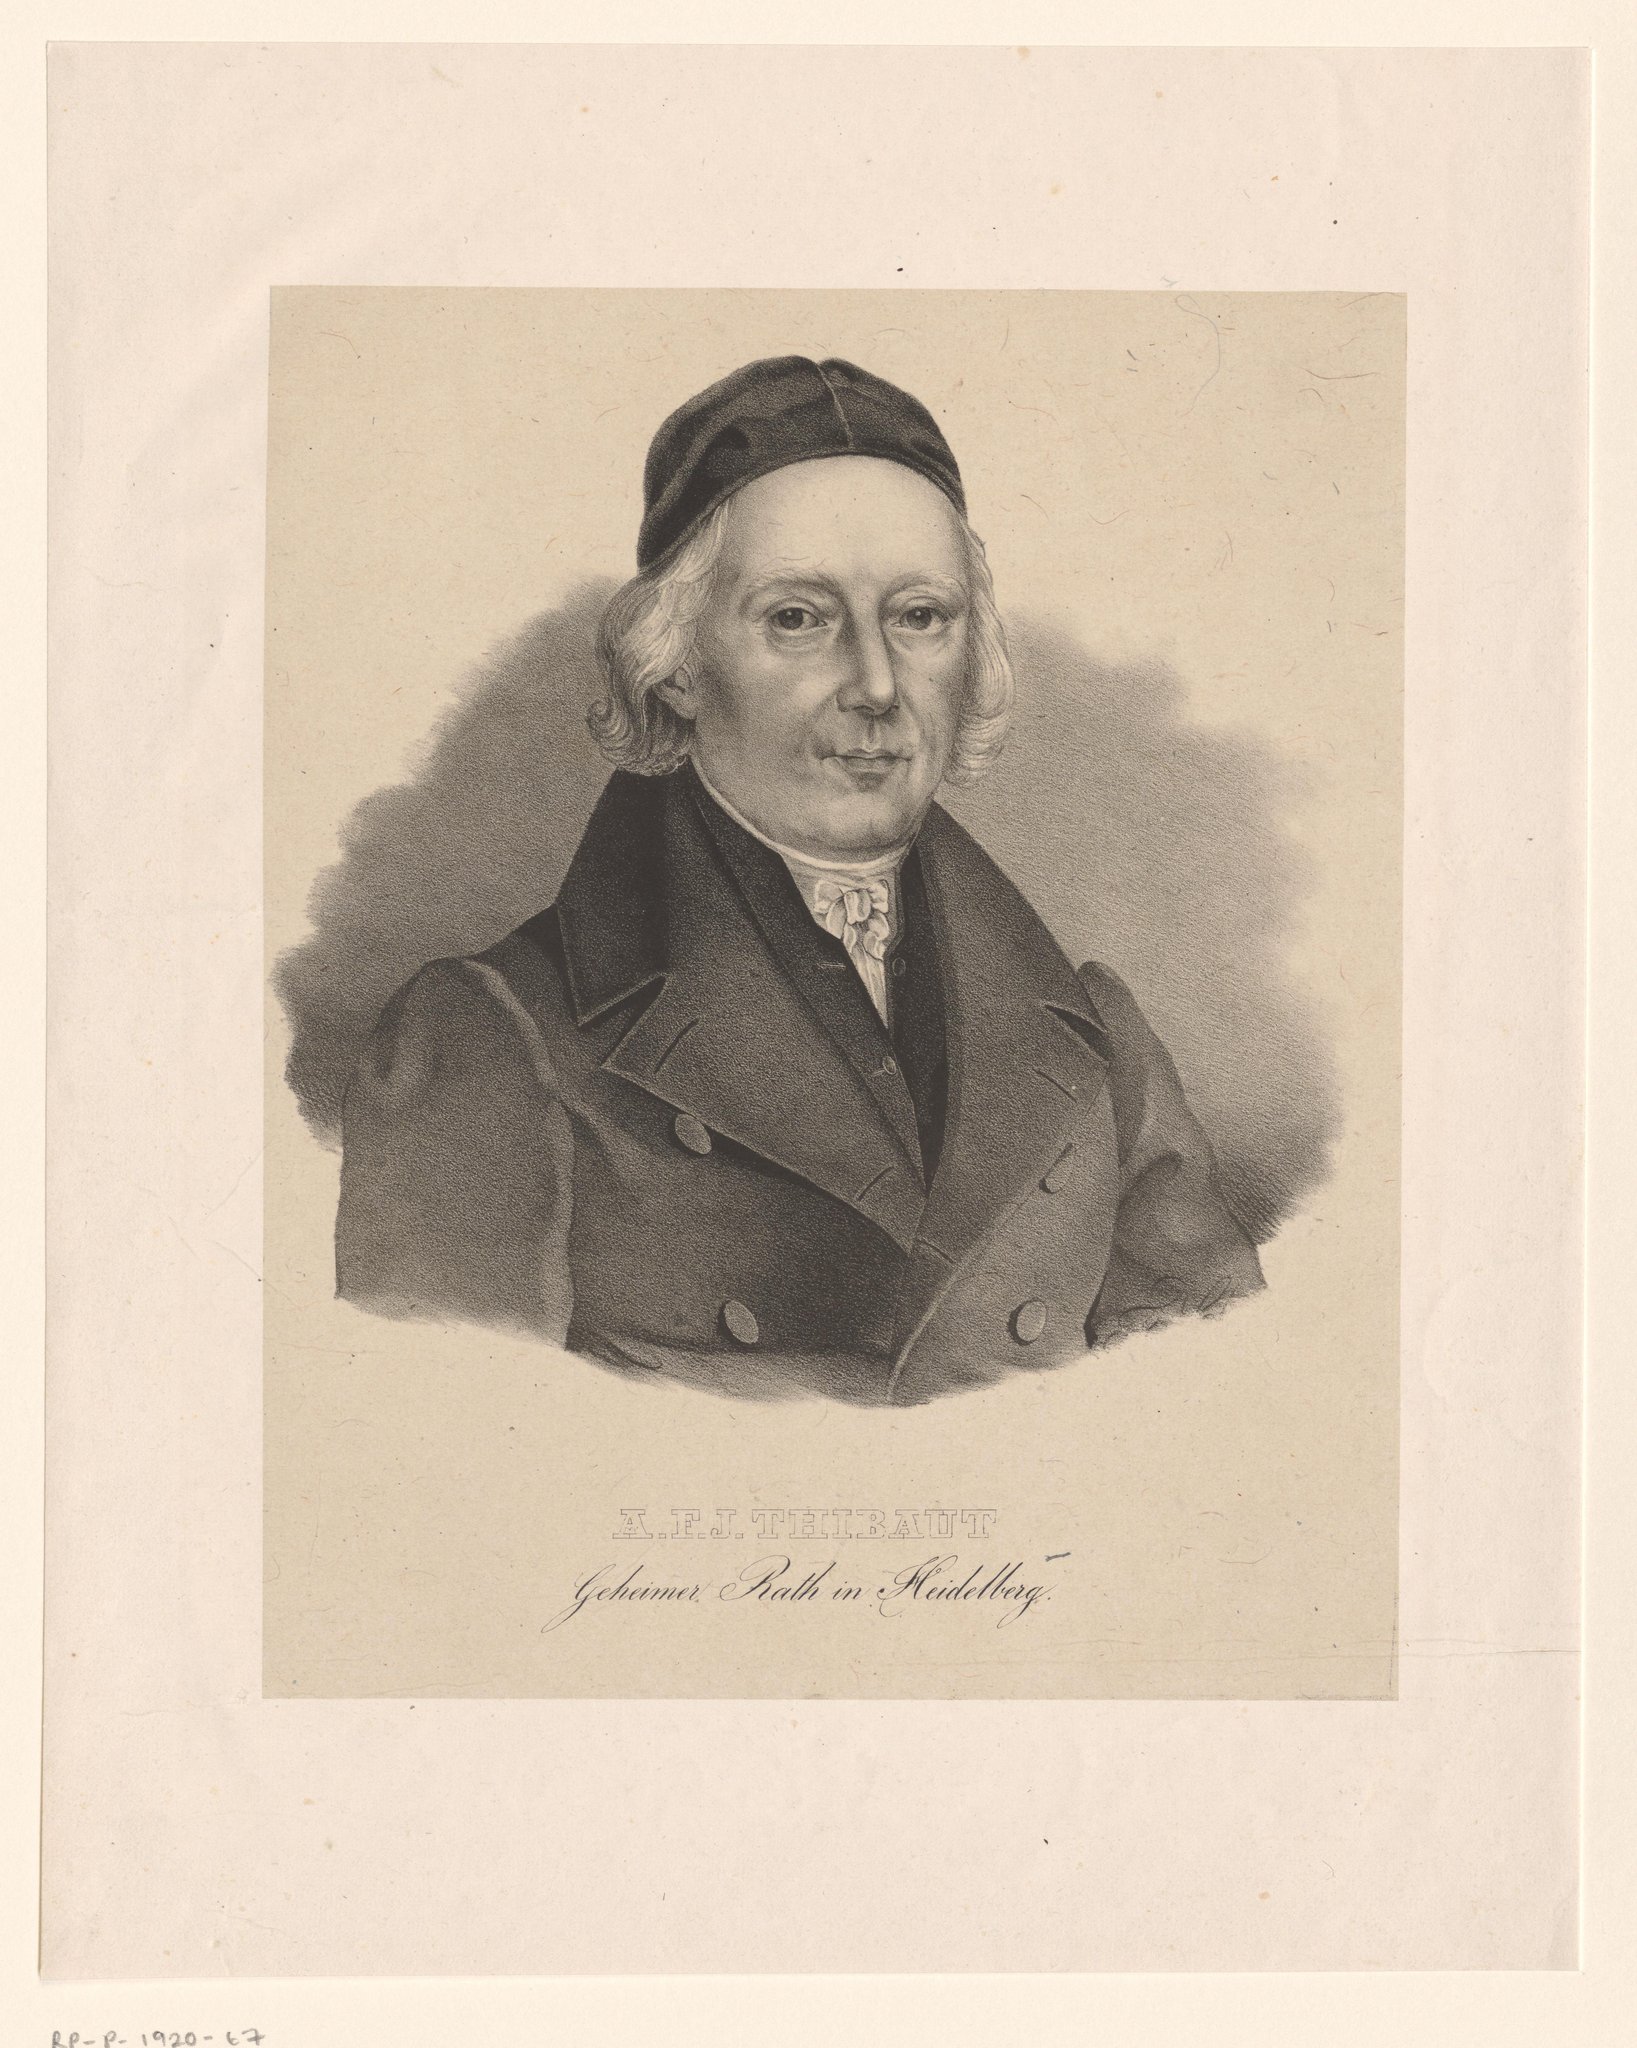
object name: print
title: Portret van Anton Friedrich Justus Thibaut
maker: Anonymous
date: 1820-1850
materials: paper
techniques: lithograph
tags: historical persons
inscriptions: collector's mark: Lugt 2228